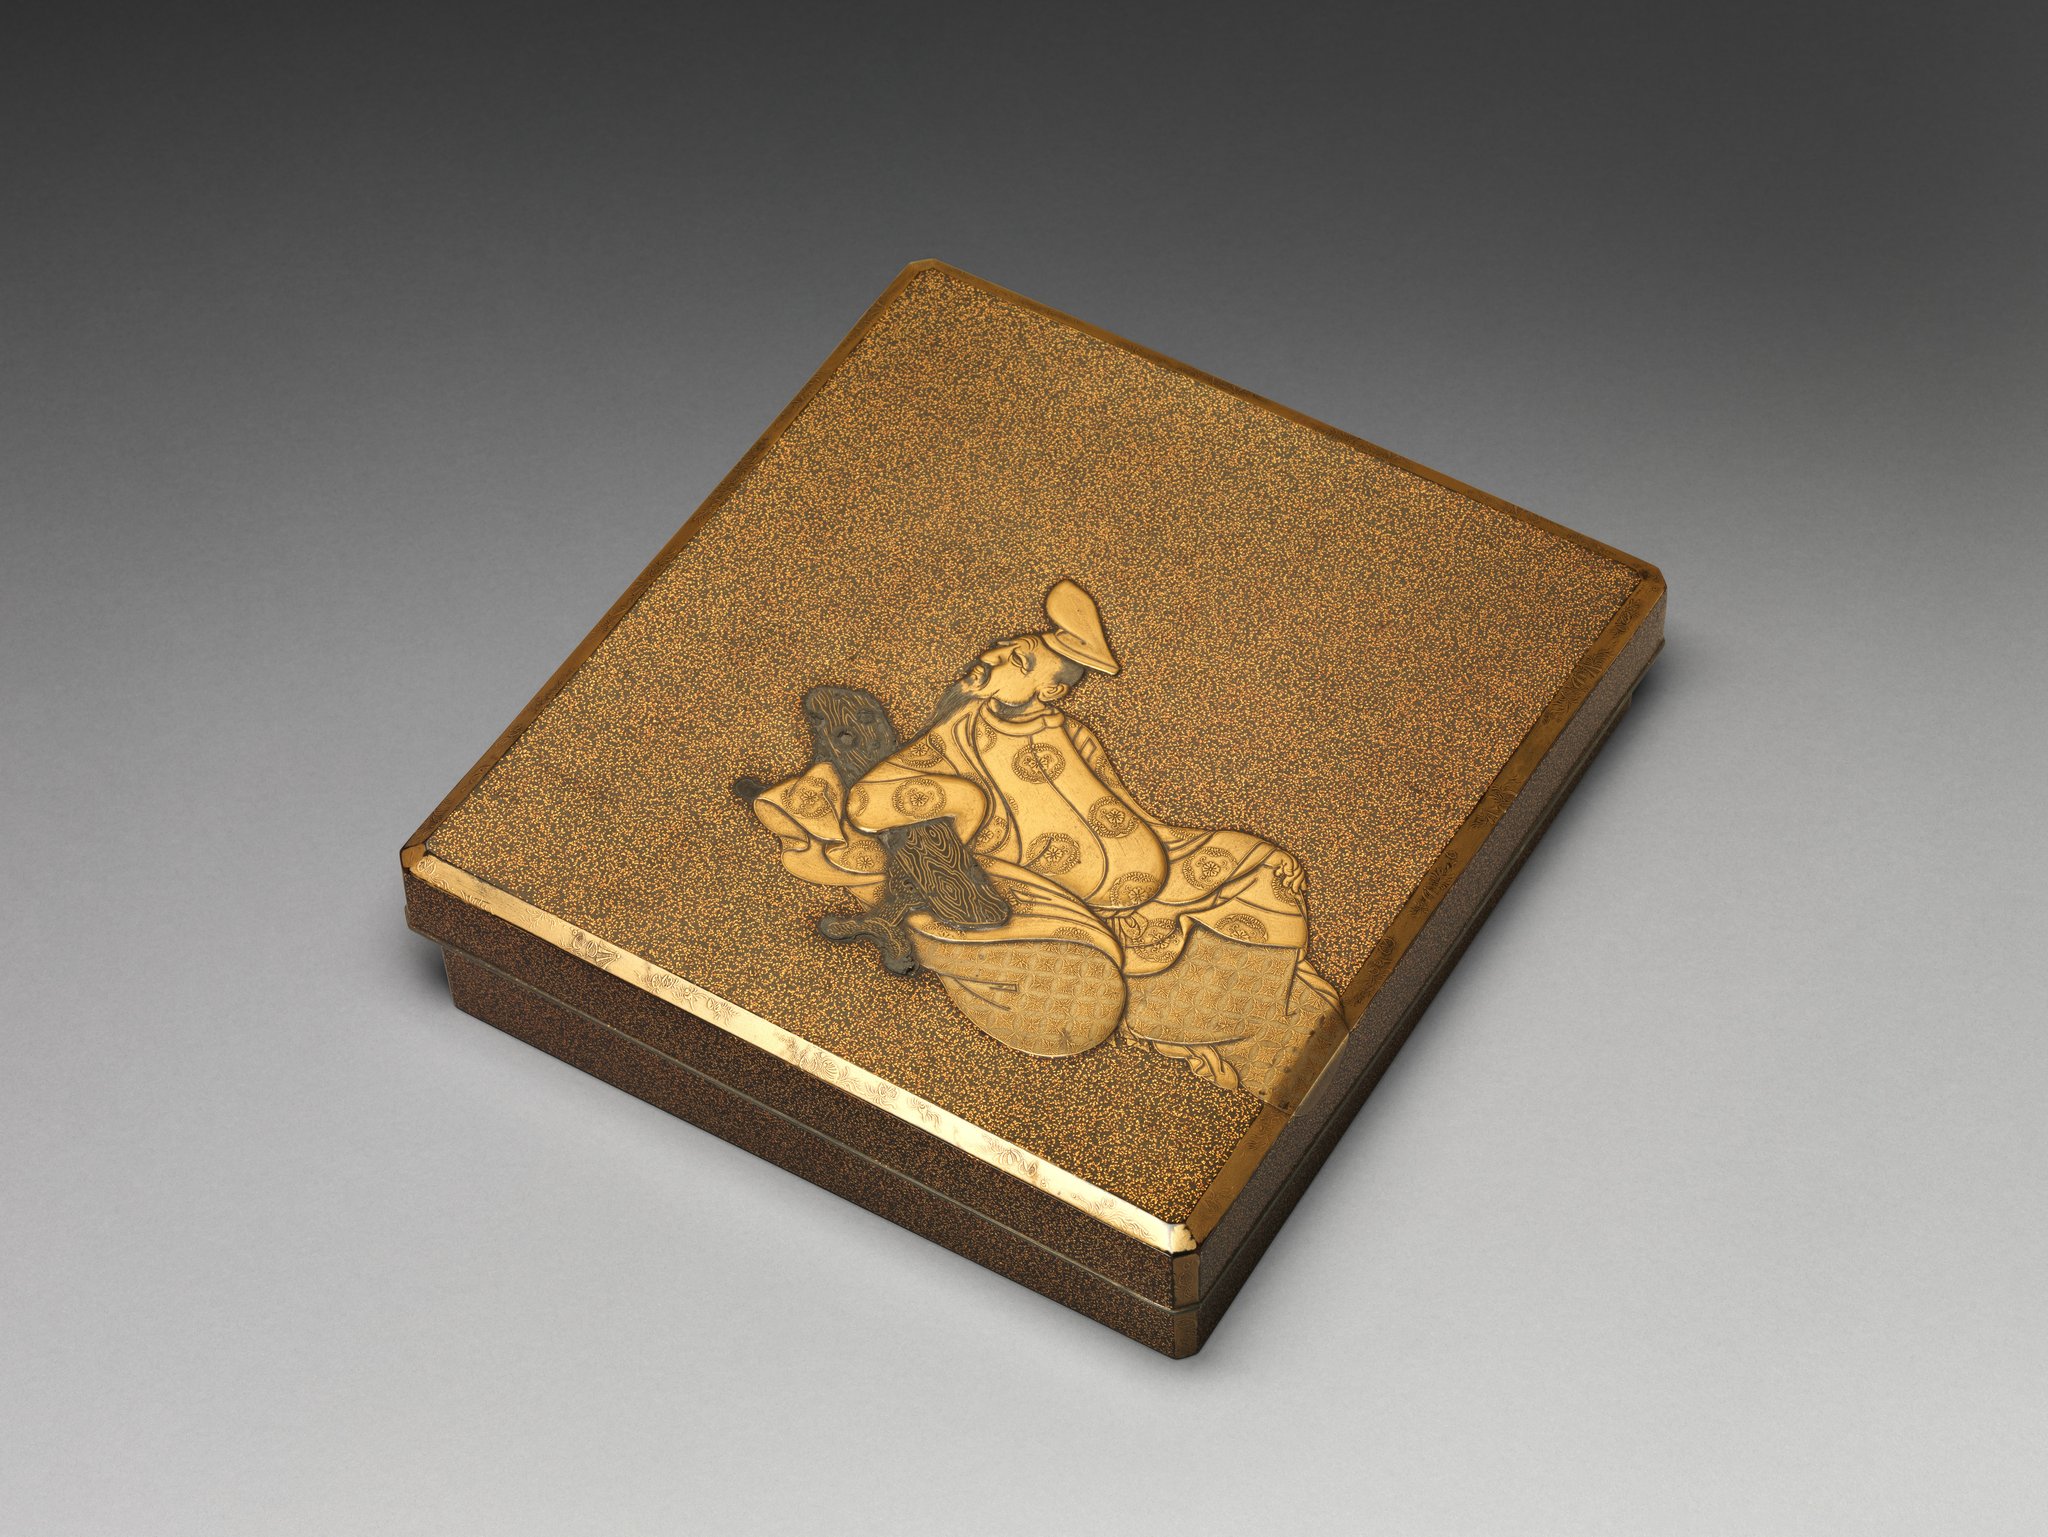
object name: writing box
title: Writing Box (Suzuribako) with the Poet Kakinomoto no Hitomaro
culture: japanese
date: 1701-1800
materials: foil, gold, lead, silver, wood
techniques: hiramakie, lacquer, maki-e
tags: men